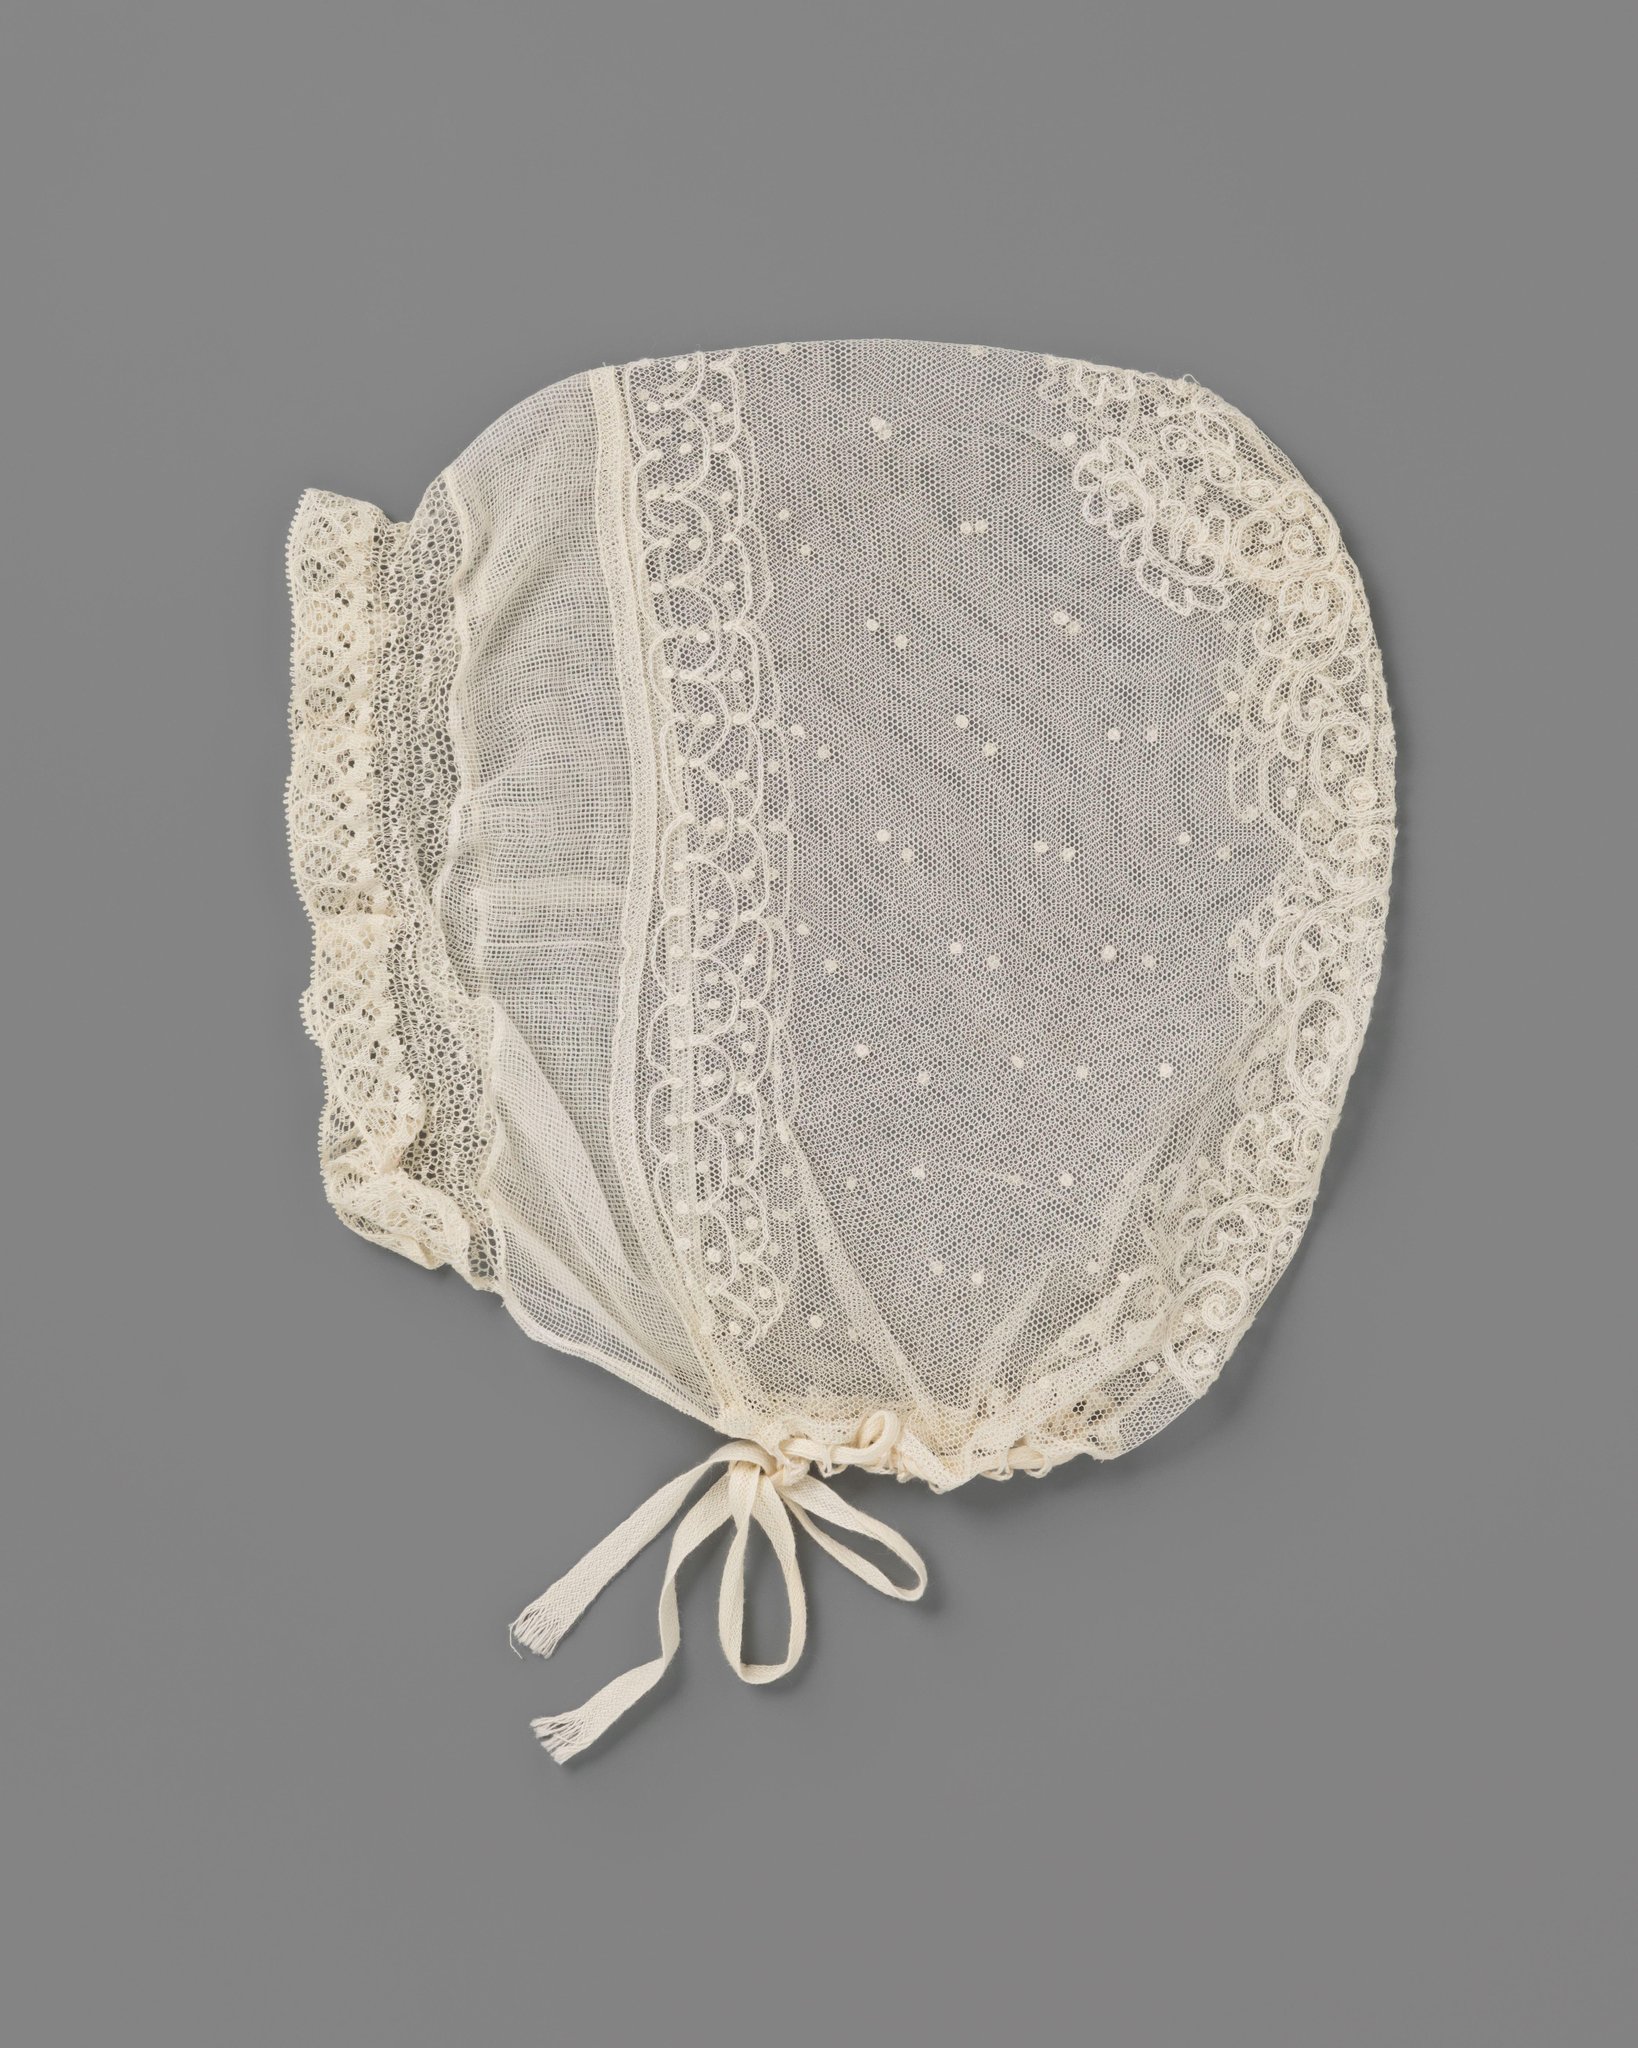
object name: womenswear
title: Muts van tule met tamboereerwerk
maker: Anonymous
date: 1925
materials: fiber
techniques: tambouring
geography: netherlands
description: Muts van tule met tamboereerwerk. Model: van een reep geknipt en met één achternaad dicht gemaakt. Met een gladde luifelstrook van gaas en machinale kant. Onderaan lussen met banden. Streekdracht?